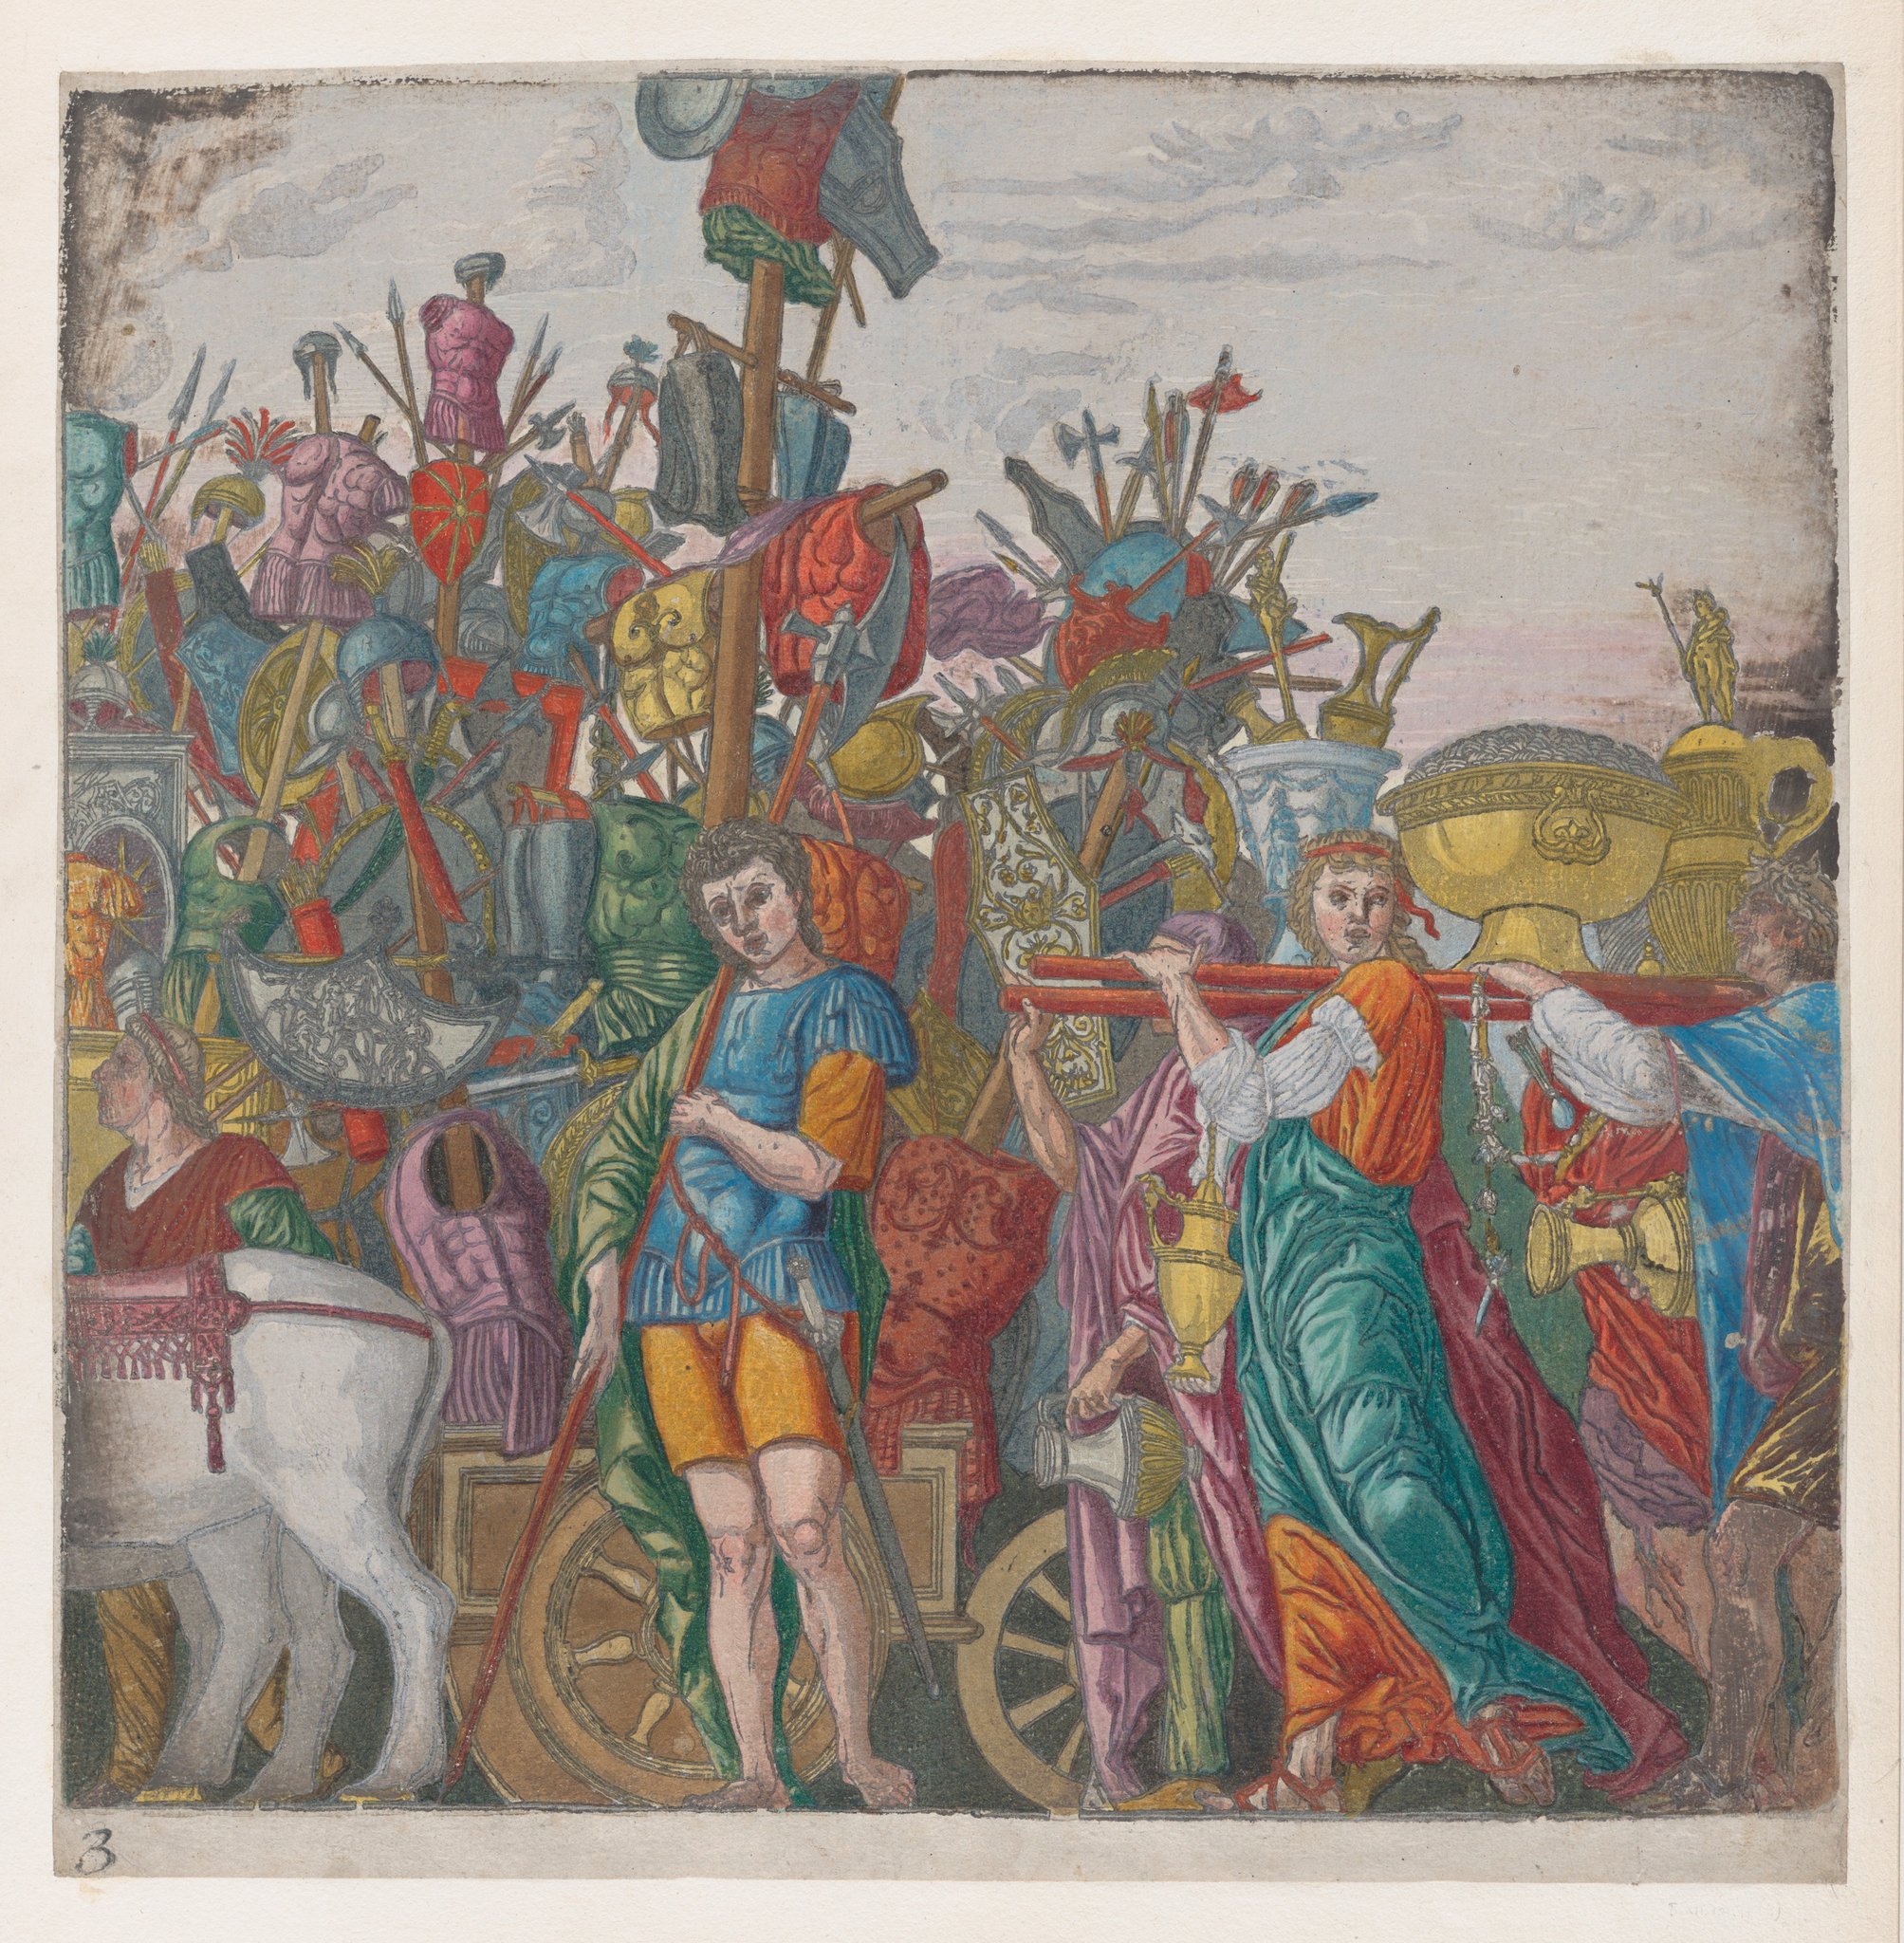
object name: print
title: Sheet 3: Trophies of War, from "The Triumph of Julius Caesar"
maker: andrea andreani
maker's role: artist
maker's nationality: italian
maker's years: 1558-1629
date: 1599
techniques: hand coloring, woodcut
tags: weapons,men,trophies